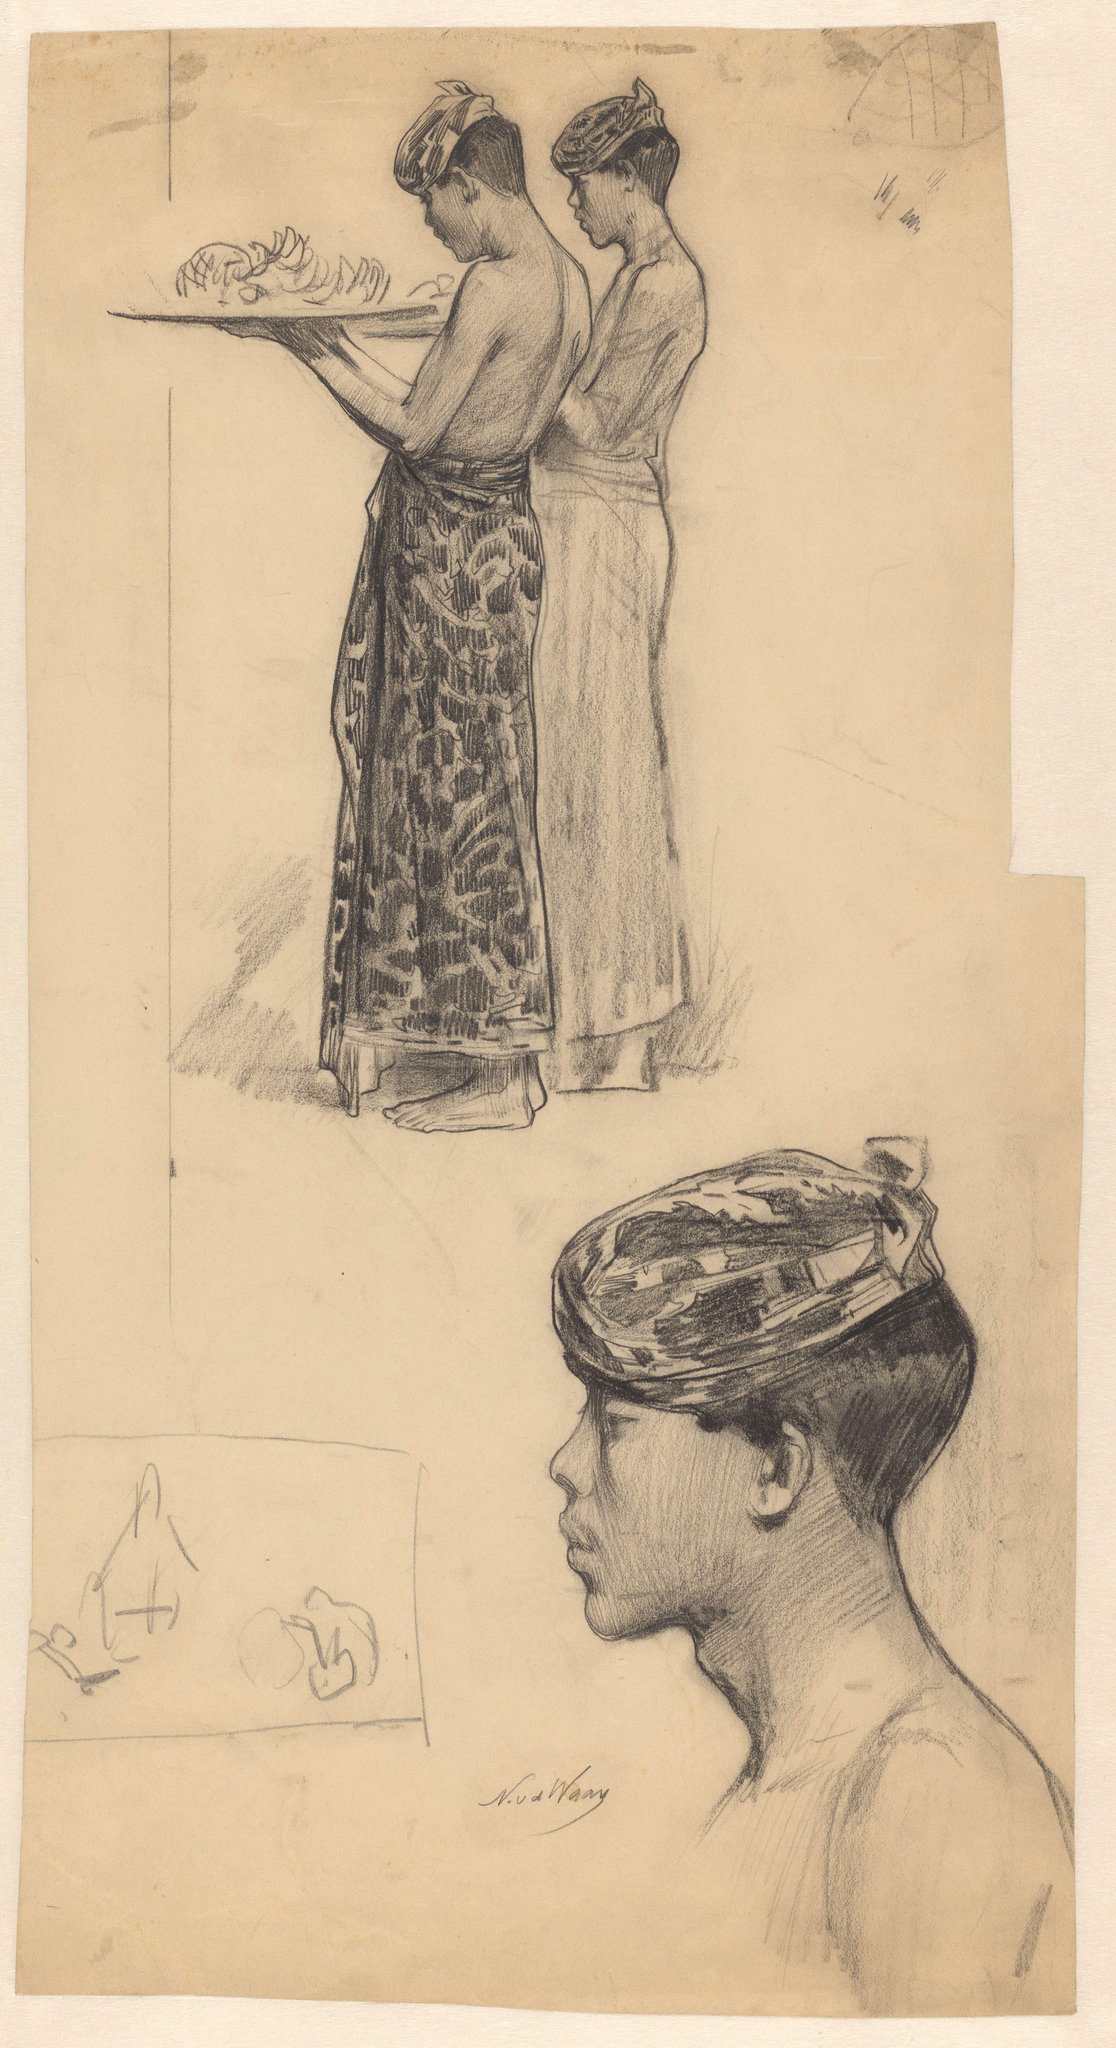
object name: drawing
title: Twee mannen uit Nederlands-Indië met dienbladen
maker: nicolaas van der waay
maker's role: draughtsman, painter, print maker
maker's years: 1855-1936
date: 1898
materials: chalk, paper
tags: asiatic races and peoples (indonesians), head-gear, house personnel, servants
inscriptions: annotation: ‘AJ [...]7/30’, collector's mark: Lugt 2228, collector's mark: Lugt 2760, number: ‘973’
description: De tekening is vermoedelijk een voorstudie voor een deel van de voorstelling op het linkerpaneel van de Gouden Koets. Dit is het paneel waarop het eerbetoon aan koningin Wilhelmina van de toenmalige koloniën Oost- en West-Indië is geschilderd. Het betreft het deel rechts waar twee jongens of jonge mannen op dienbladen producten uit de toenmalige koloniën aanbieden aan de Nederlandse Maagd. Op deze tekening is hun bovenlichaam echter onbedekt. Volgens het inventarisboek gaat het om Javaanse mannen.